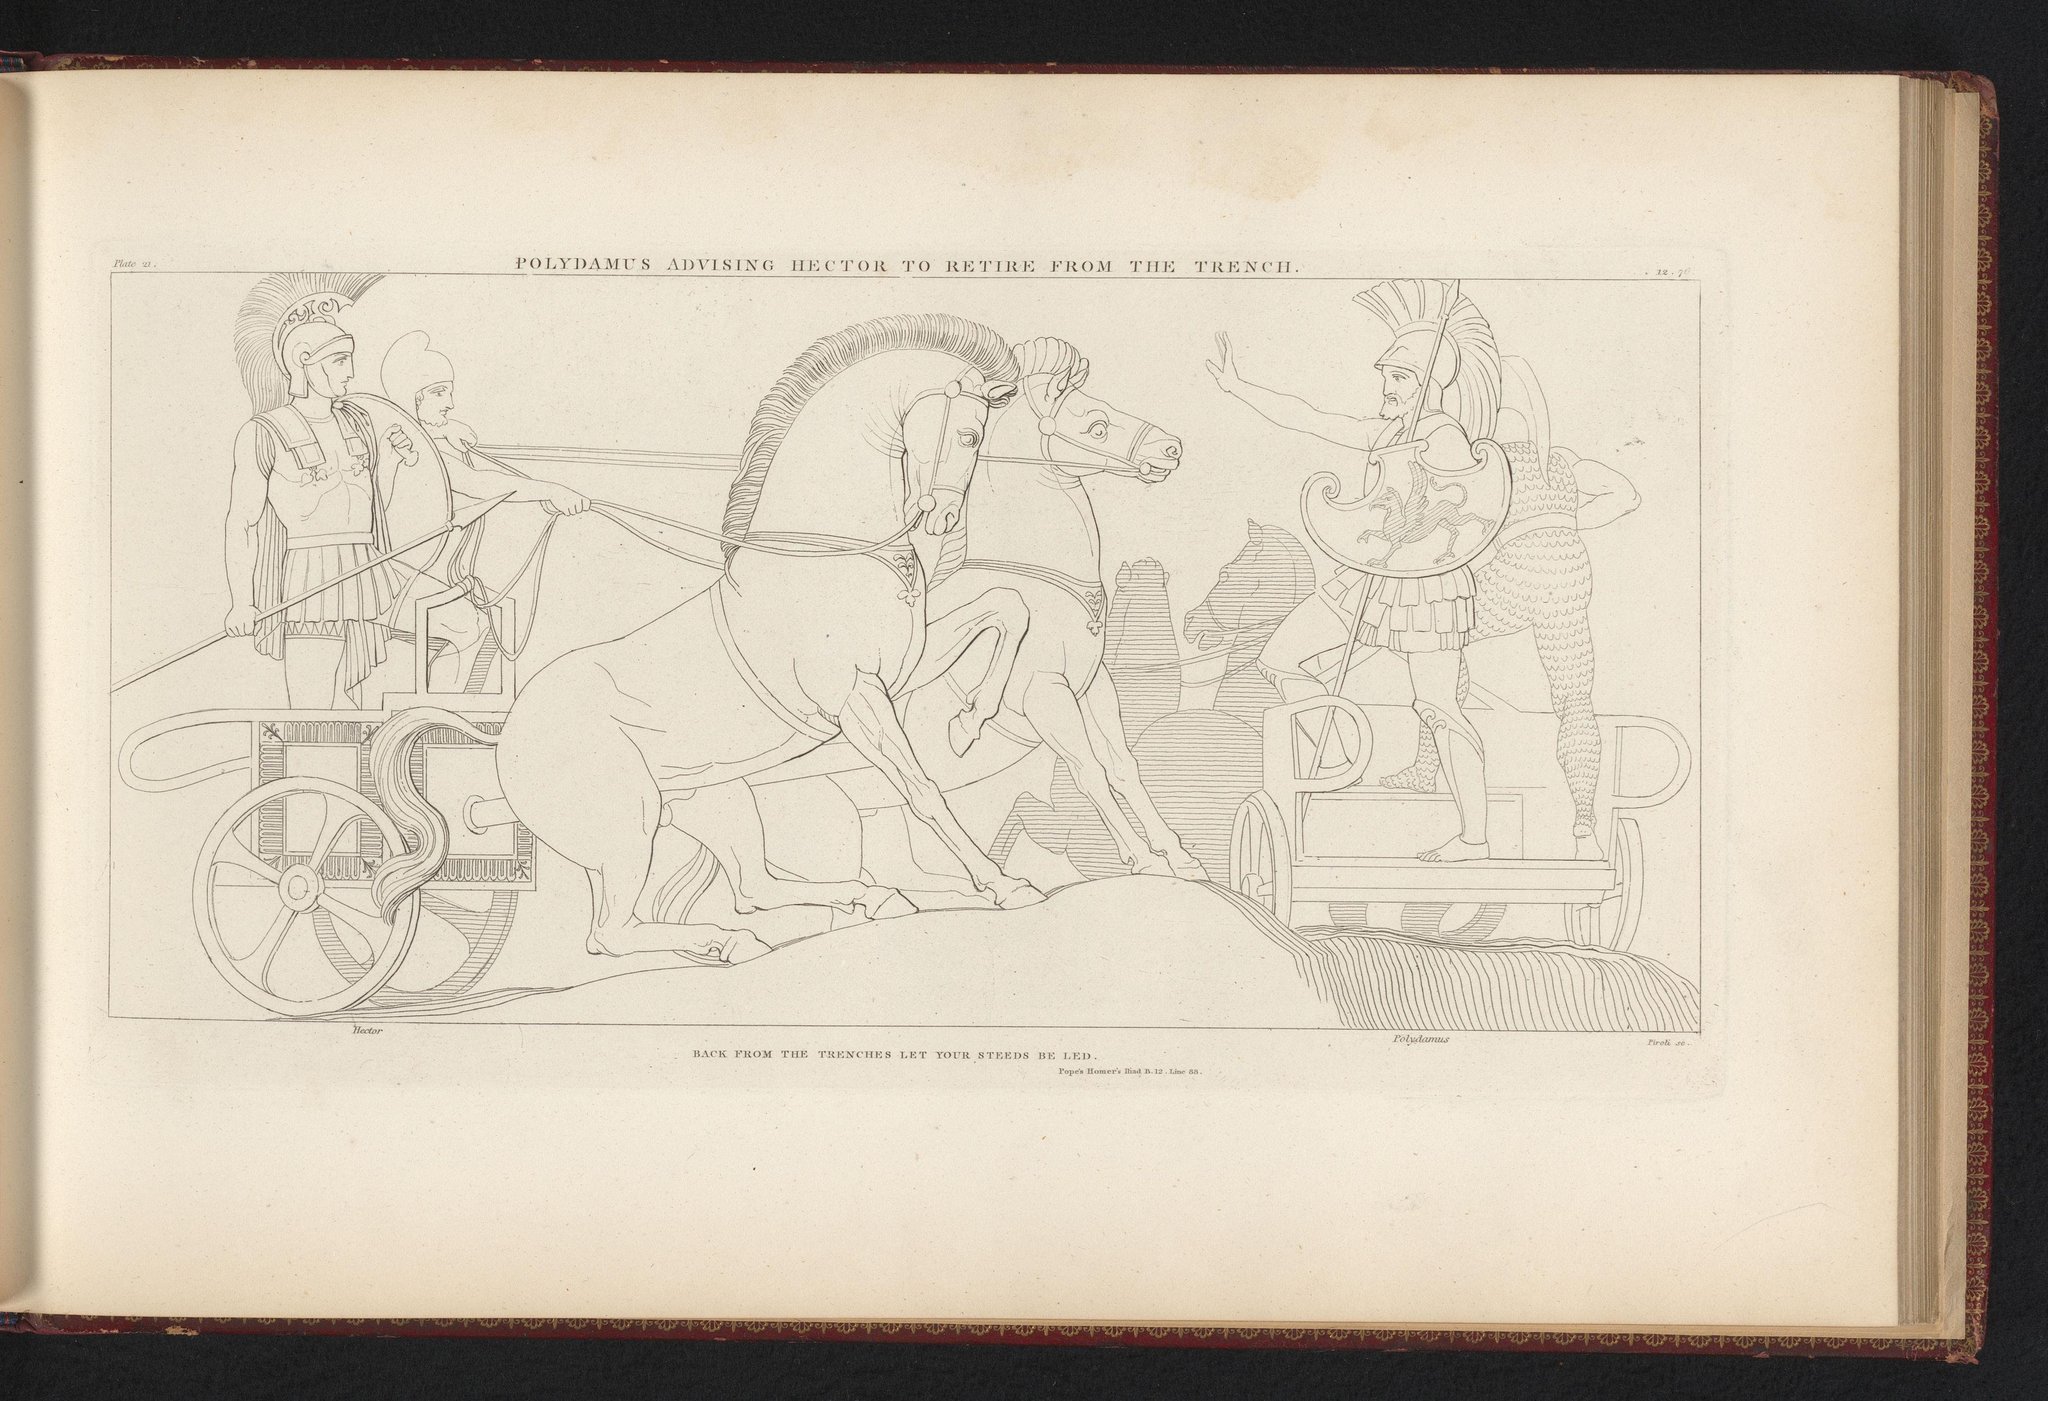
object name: album leaf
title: Ilias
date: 1805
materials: paper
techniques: etching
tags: hector's last fight and death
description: Prent maakt onderdeel uit van een serie met 39 prenten over de Ilias, geschreven door Homerus.